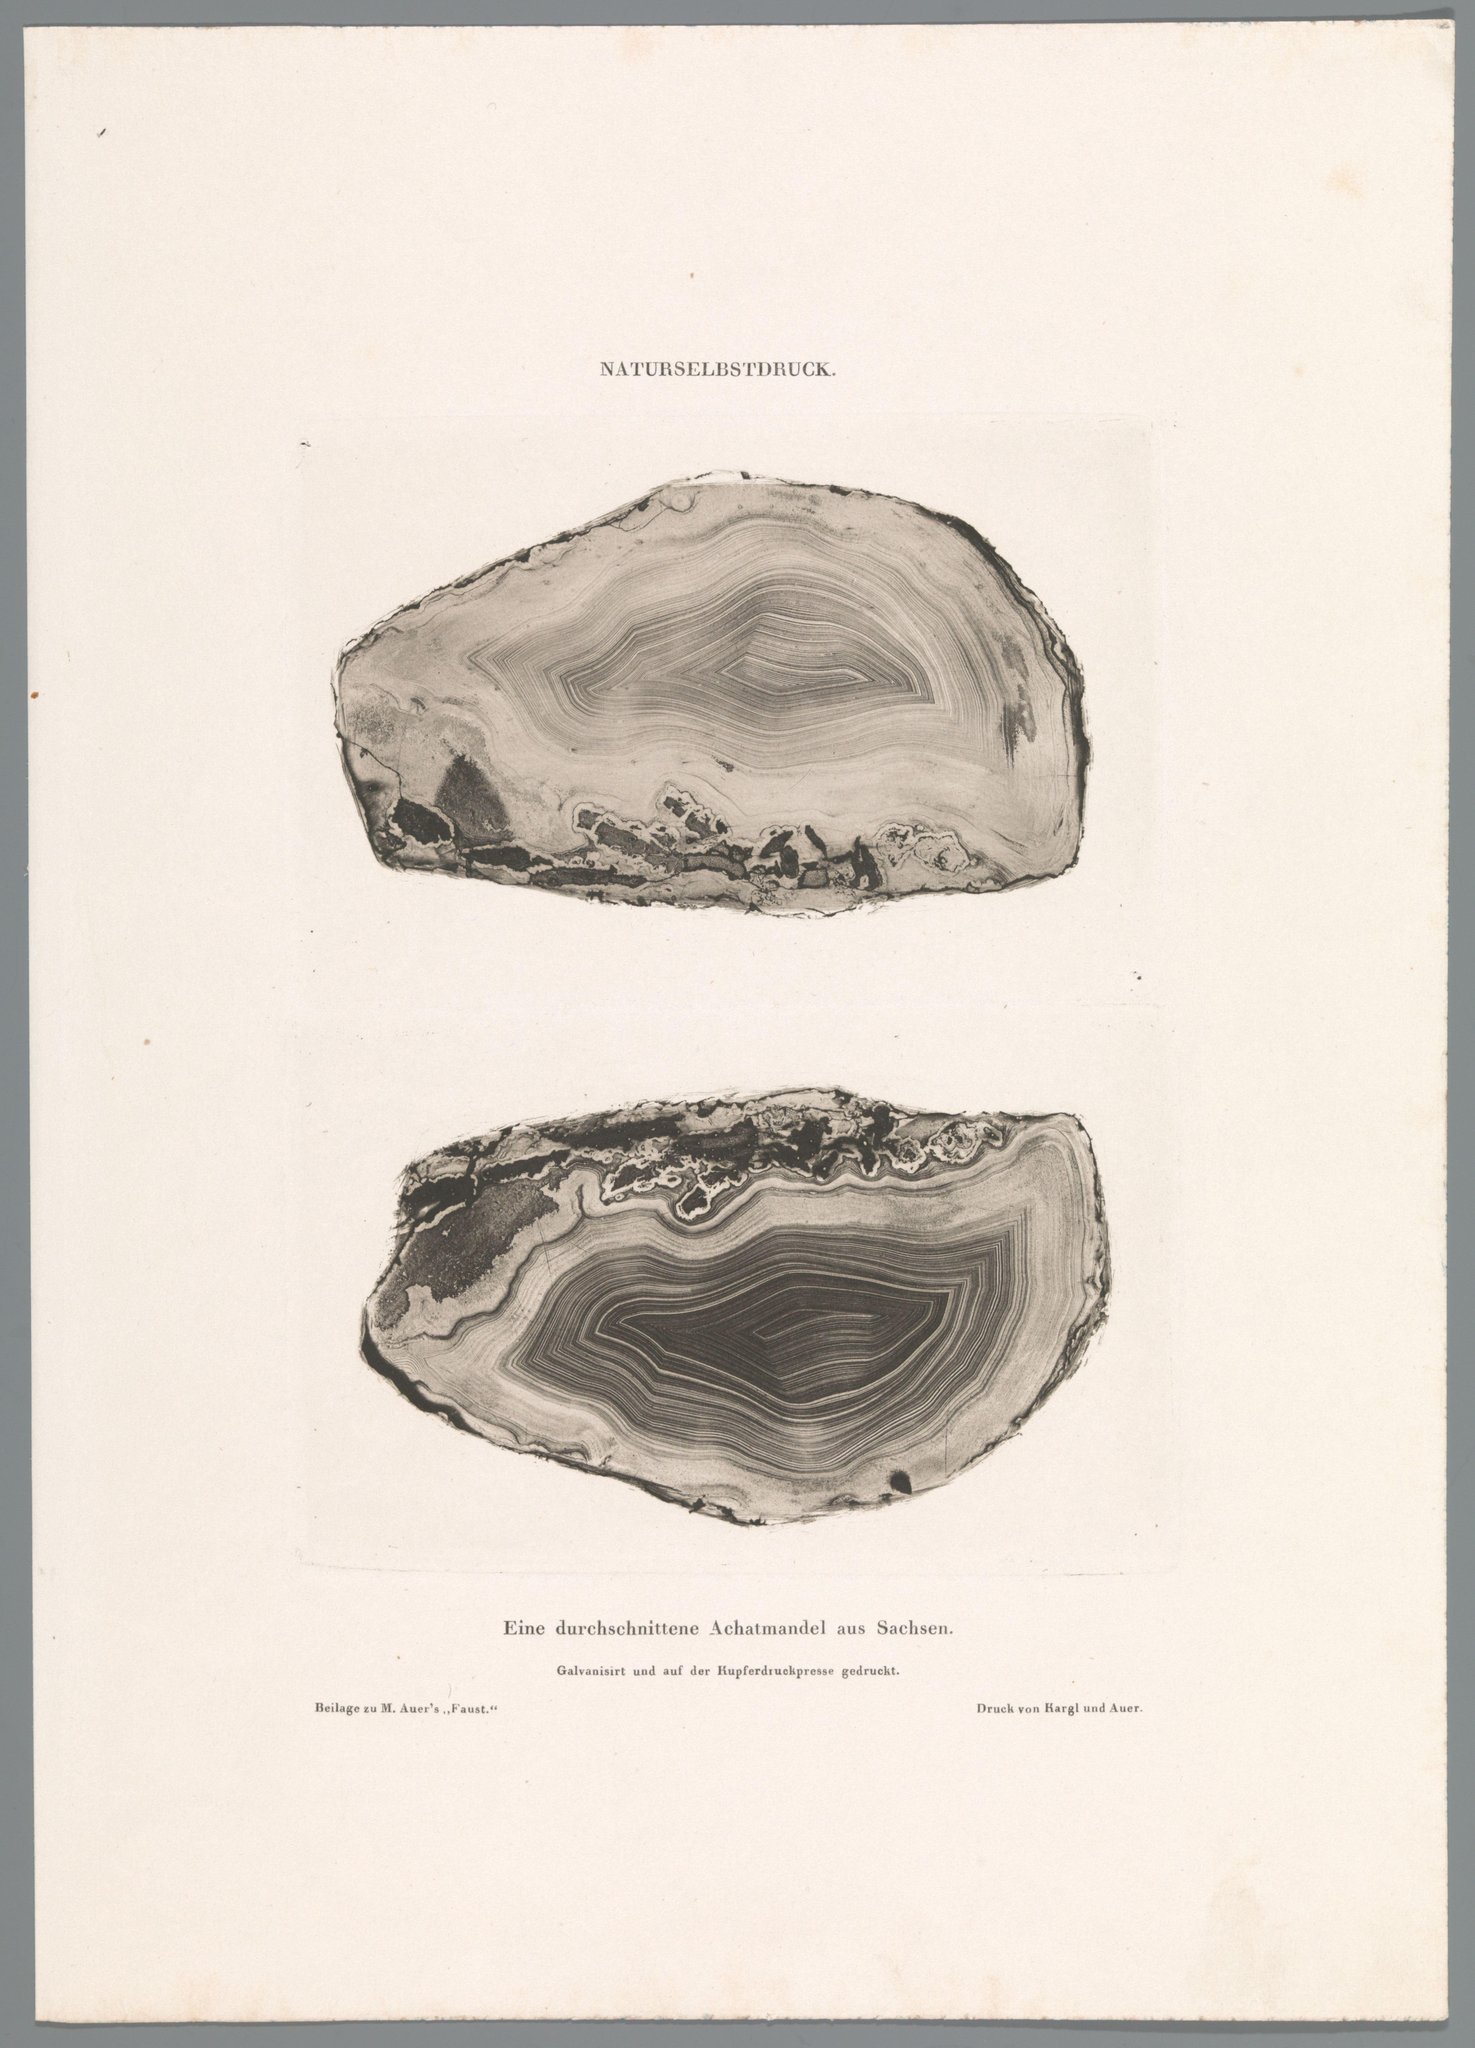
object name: print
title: Doorsnede van een achatmandel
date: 1855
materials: paper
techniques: nature print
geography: vienna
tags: minerals and metals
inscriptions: inscription: ‘NATURSELBSTDRUCK./ Eine durchschnittene Achatmandel aus Sachsen./ Galvanisirt und auf der Kupferdruckpresse gedruckt./ Beilage zu M. Auer's "Faust."’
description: Blad uit reeks van 12 Naturselbstdrucke Auer.